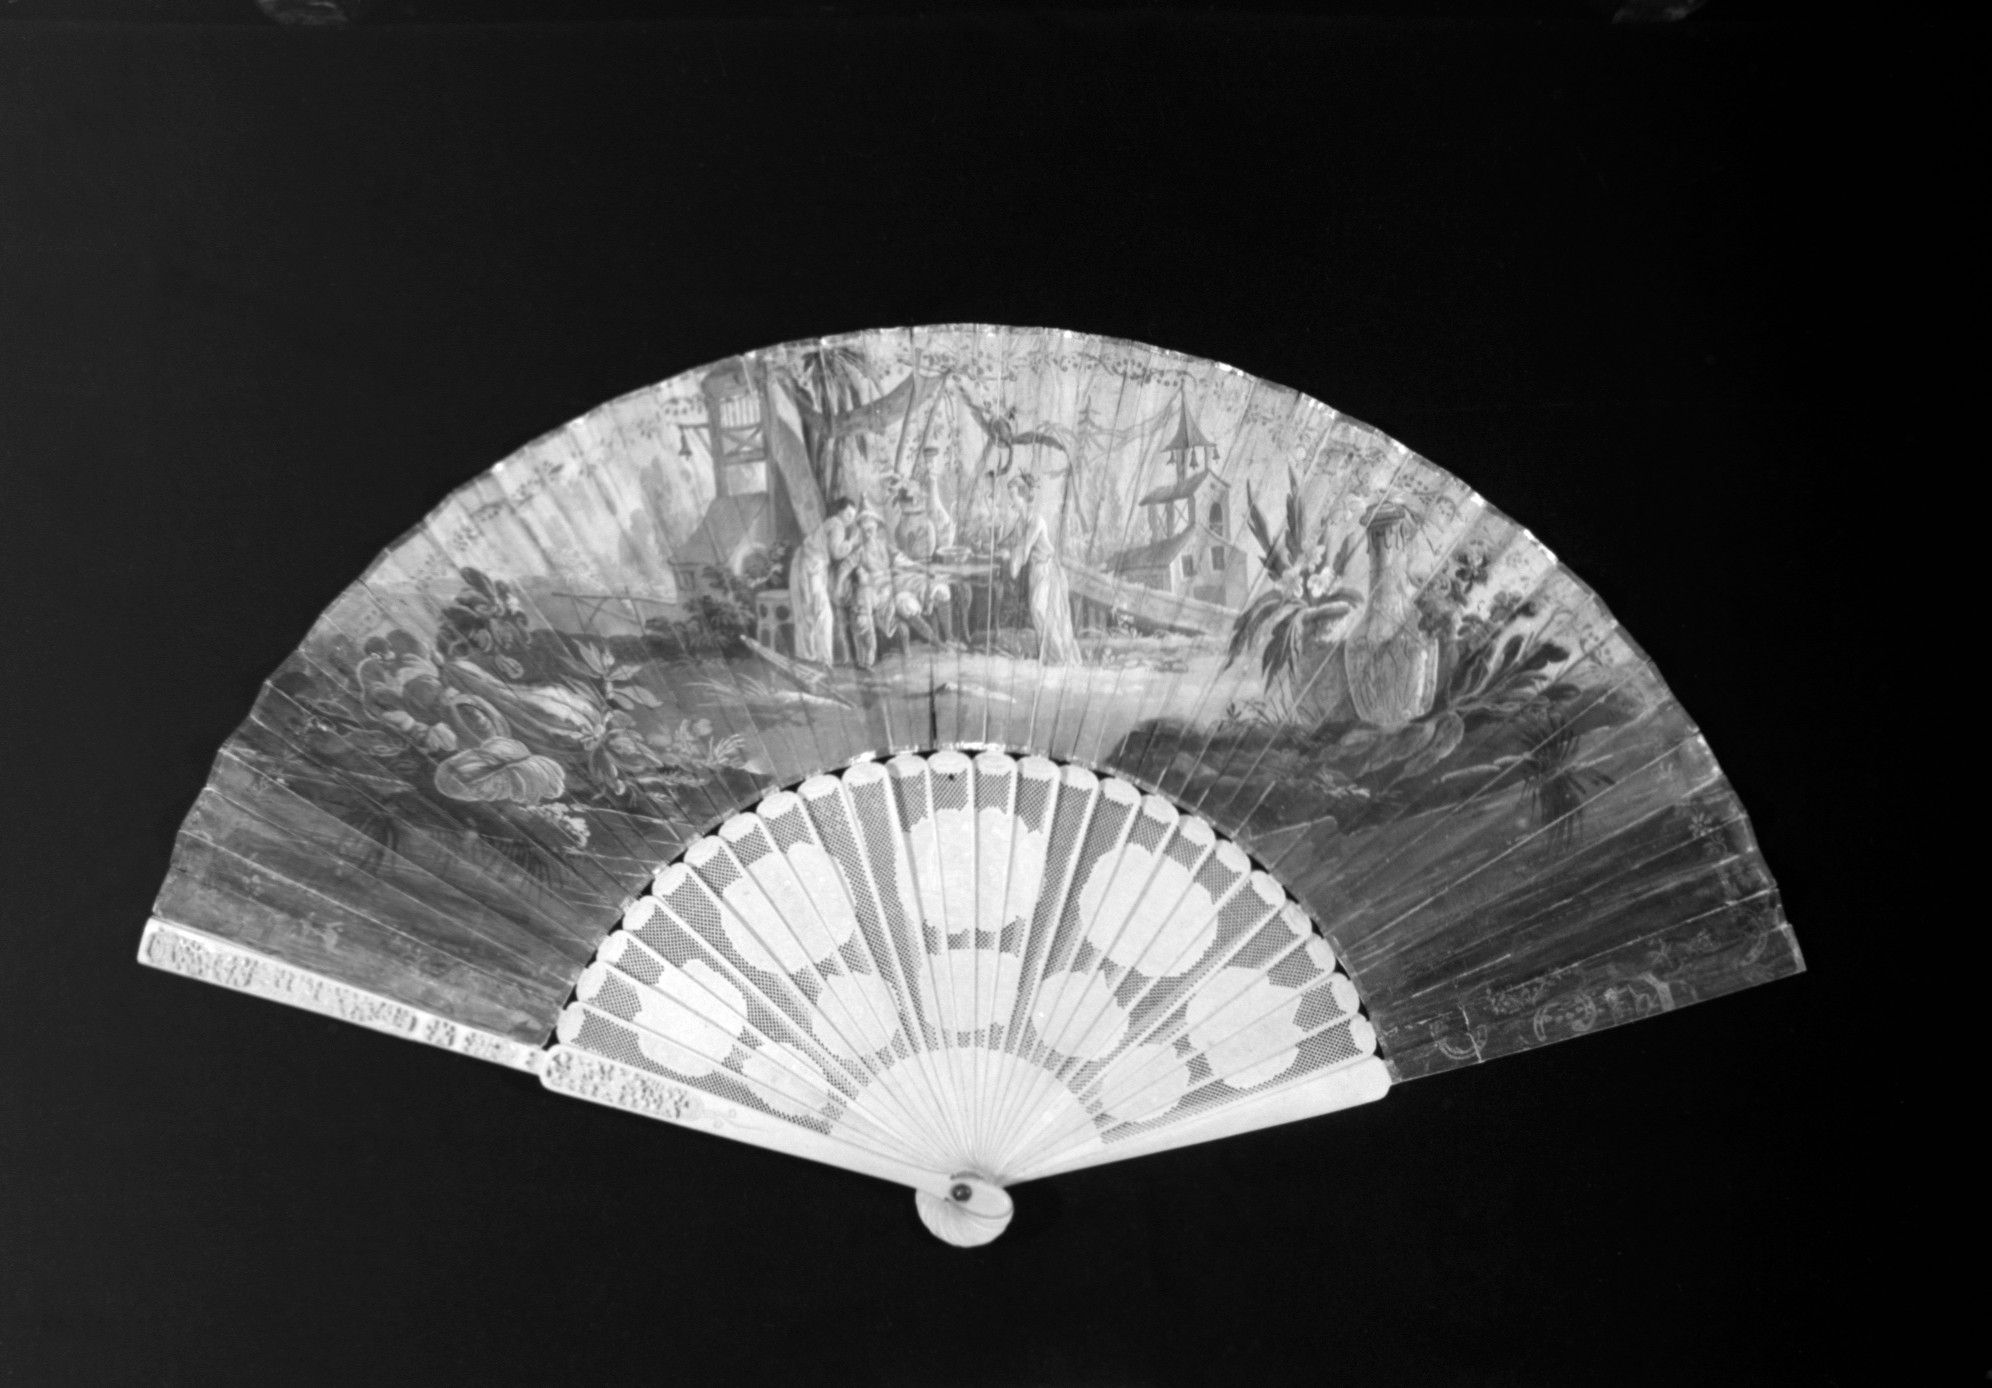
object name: fan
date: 1701-1800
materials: ivory, paper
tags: men,women